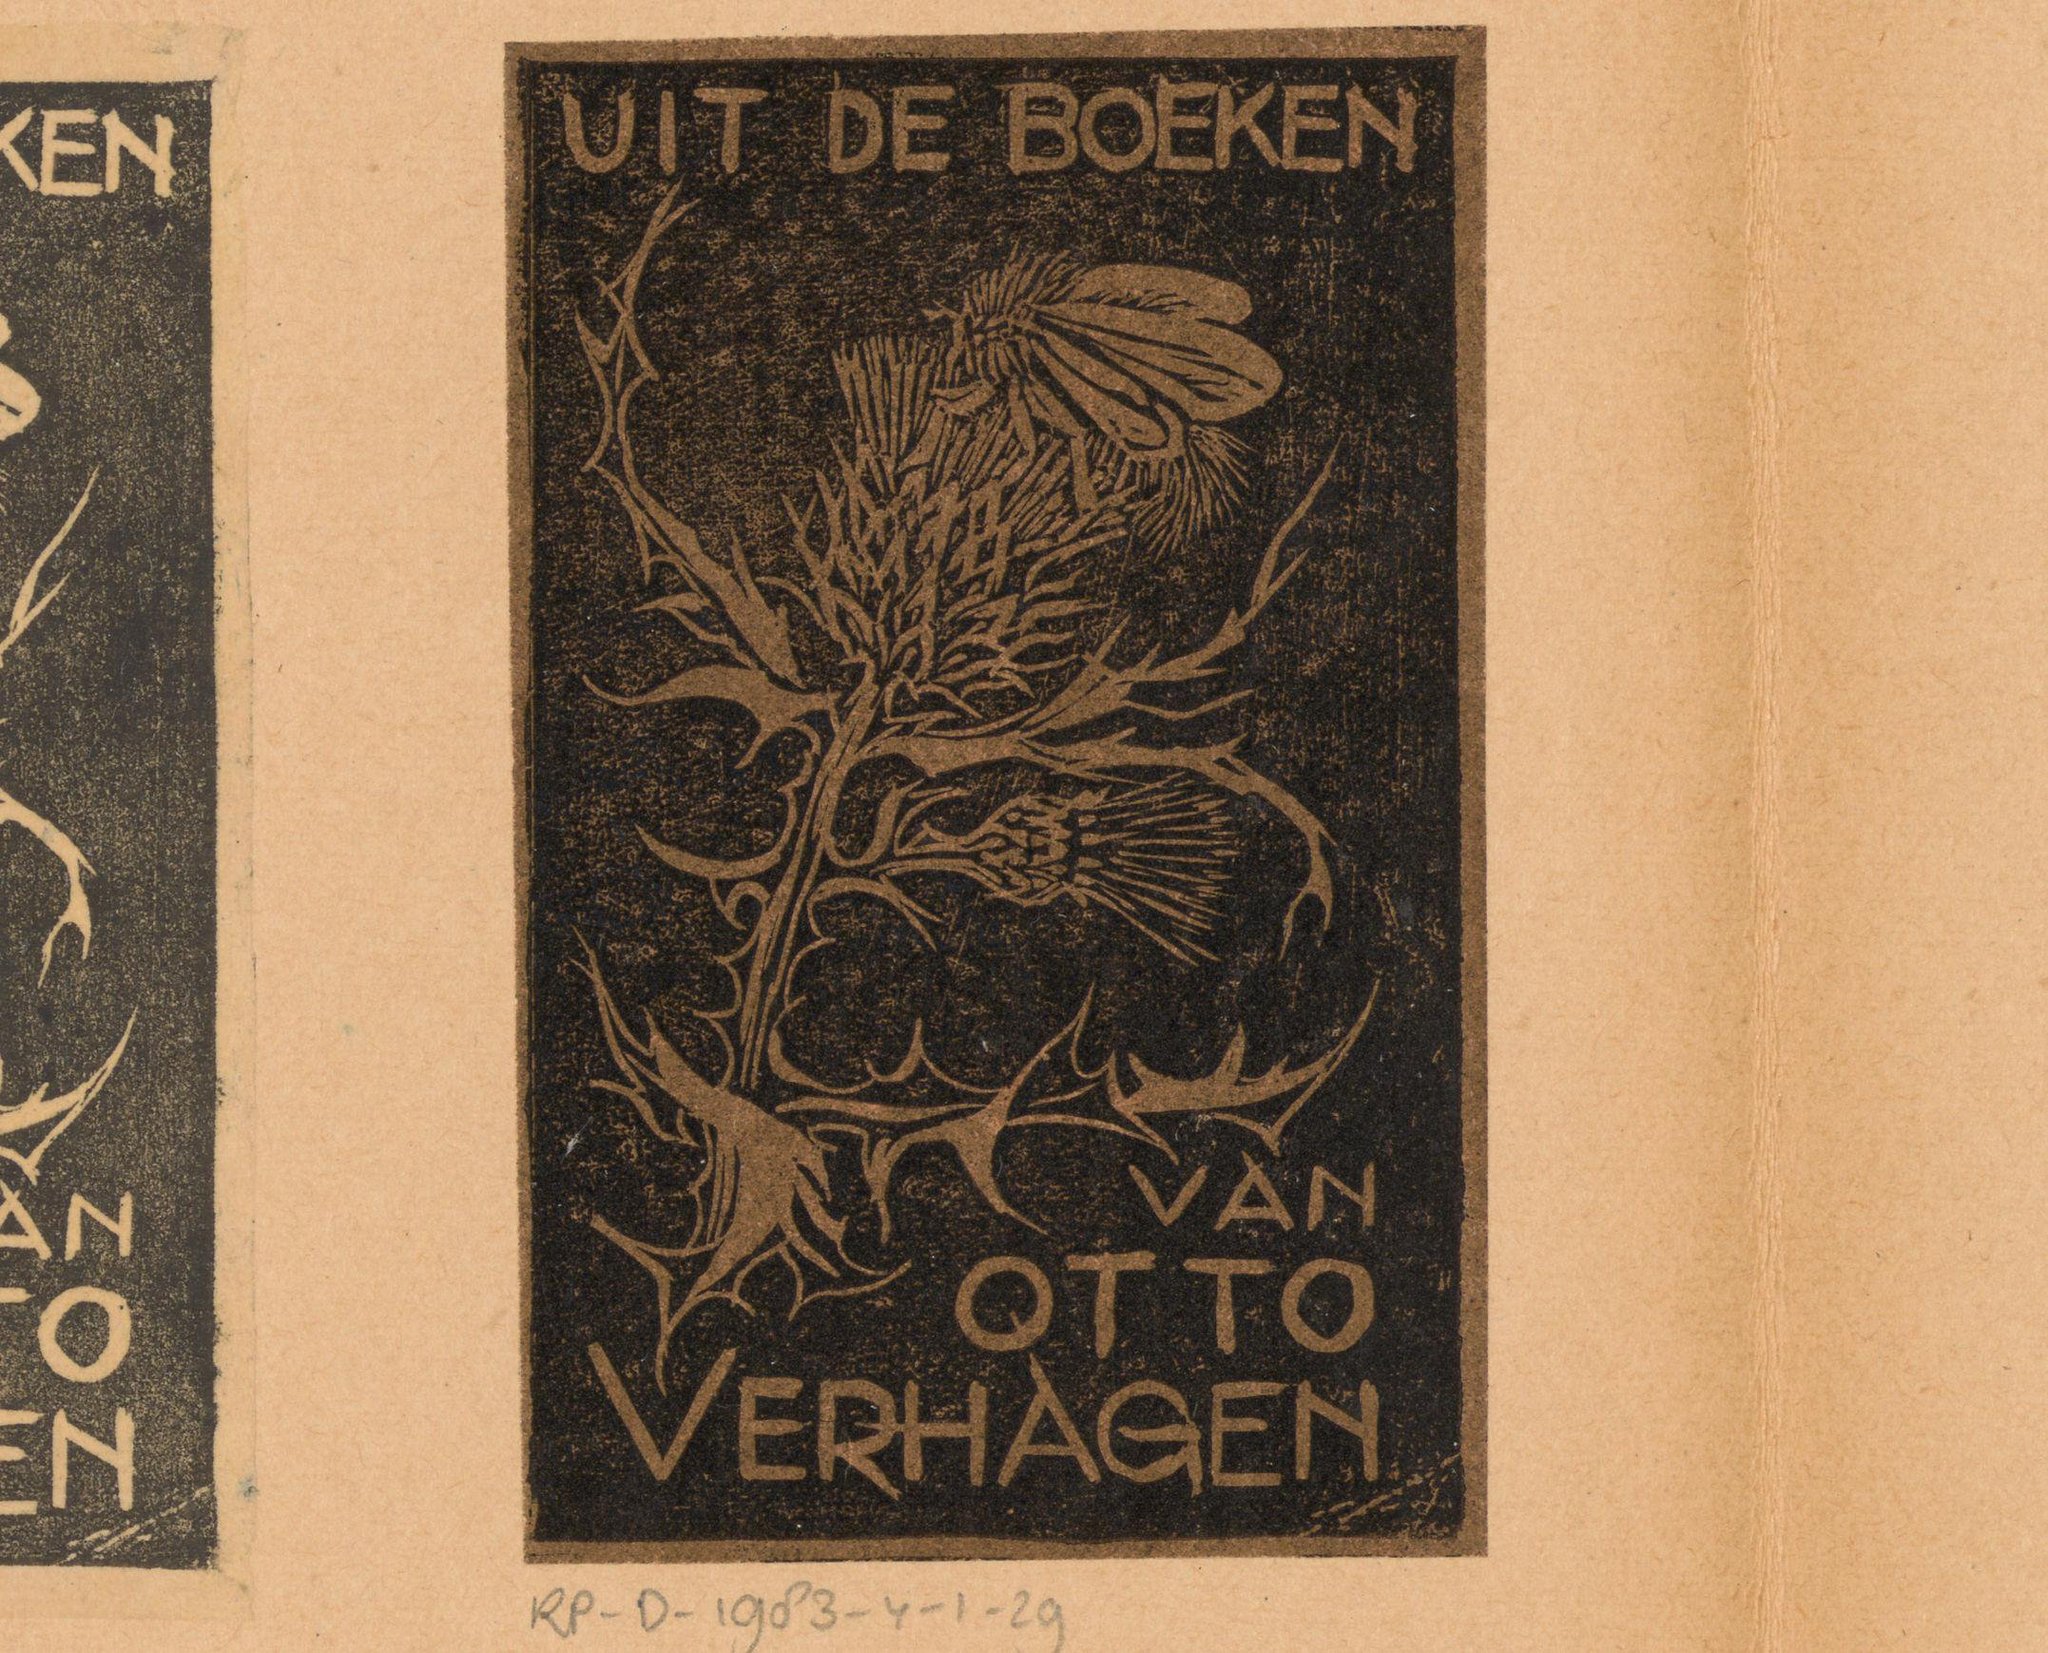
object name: bookplate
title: Ex libris van Otto Verhagen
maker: otto verhagen (i)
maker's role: draughtsman, print maker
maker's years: 1885-1951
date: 1929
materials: paper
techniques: woodcut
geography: netherlands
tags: the hague, draughtsman, otto verhagen (i), insects: bee, plants and herbs: thistle